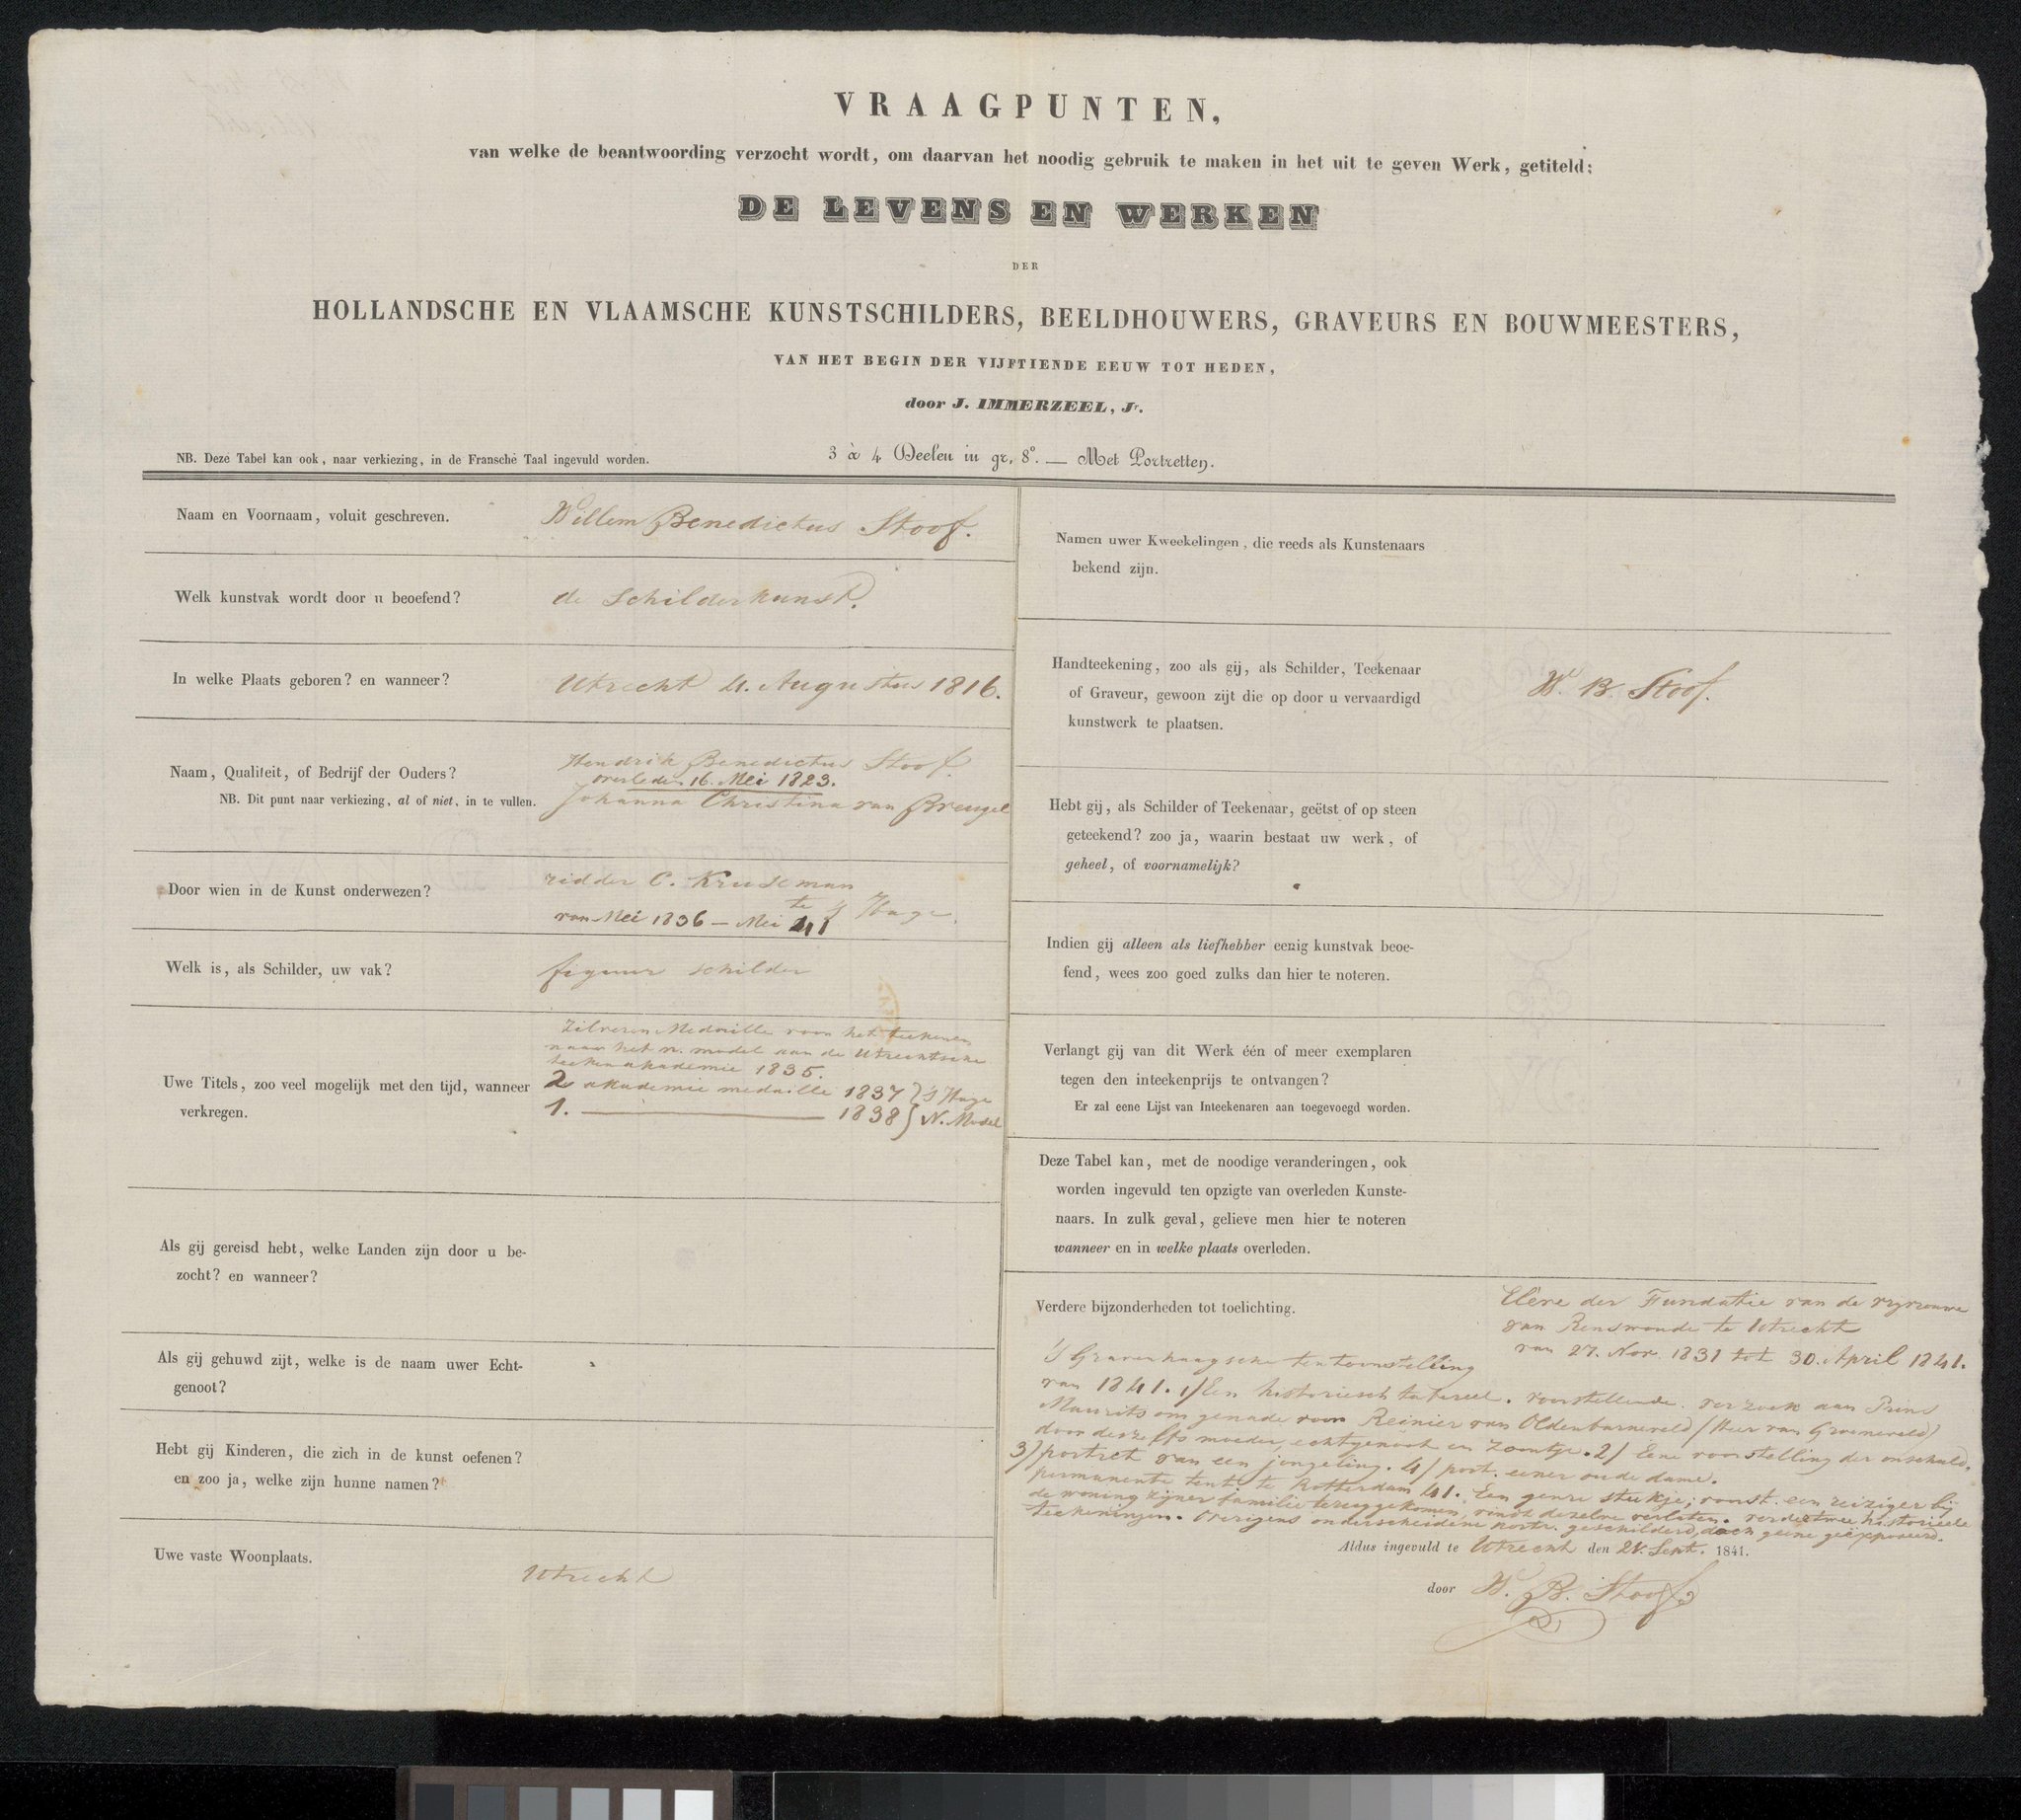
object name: questionnaire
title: Enquêteformulier ingevuld door Willem Benedictus Stoof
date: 1841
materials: ink, paper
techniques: pen, printing, writing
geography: utrecht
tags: utrecht, print maker, willem benedictus stoof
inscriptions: watermark, inscription: ‘Vraagpunten,/ van welke de beantwoording verzocht wordt, om daarvan het noodig gebruik te maken in het uit te geven Werk, getiteld: De levens en werken/ der Hollandsche en Vlaamsche kunstschilders, beeldhouwers,/ graveurs en bouwmeesters, van het begin der vijftiende eeuw tot heden/ door J. Immerzeel, Jr.’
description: Opgenomen in: Immerzeel, J. Jr., De levens en werken der Hollandsche en Vlaamsche kunstschilders, beeldhouwers, graveurs en bouwmeesters, van het begin der vijftiende eeuw tot heden, Amsterdam: J.C. van Kesteren, 1842-1843.